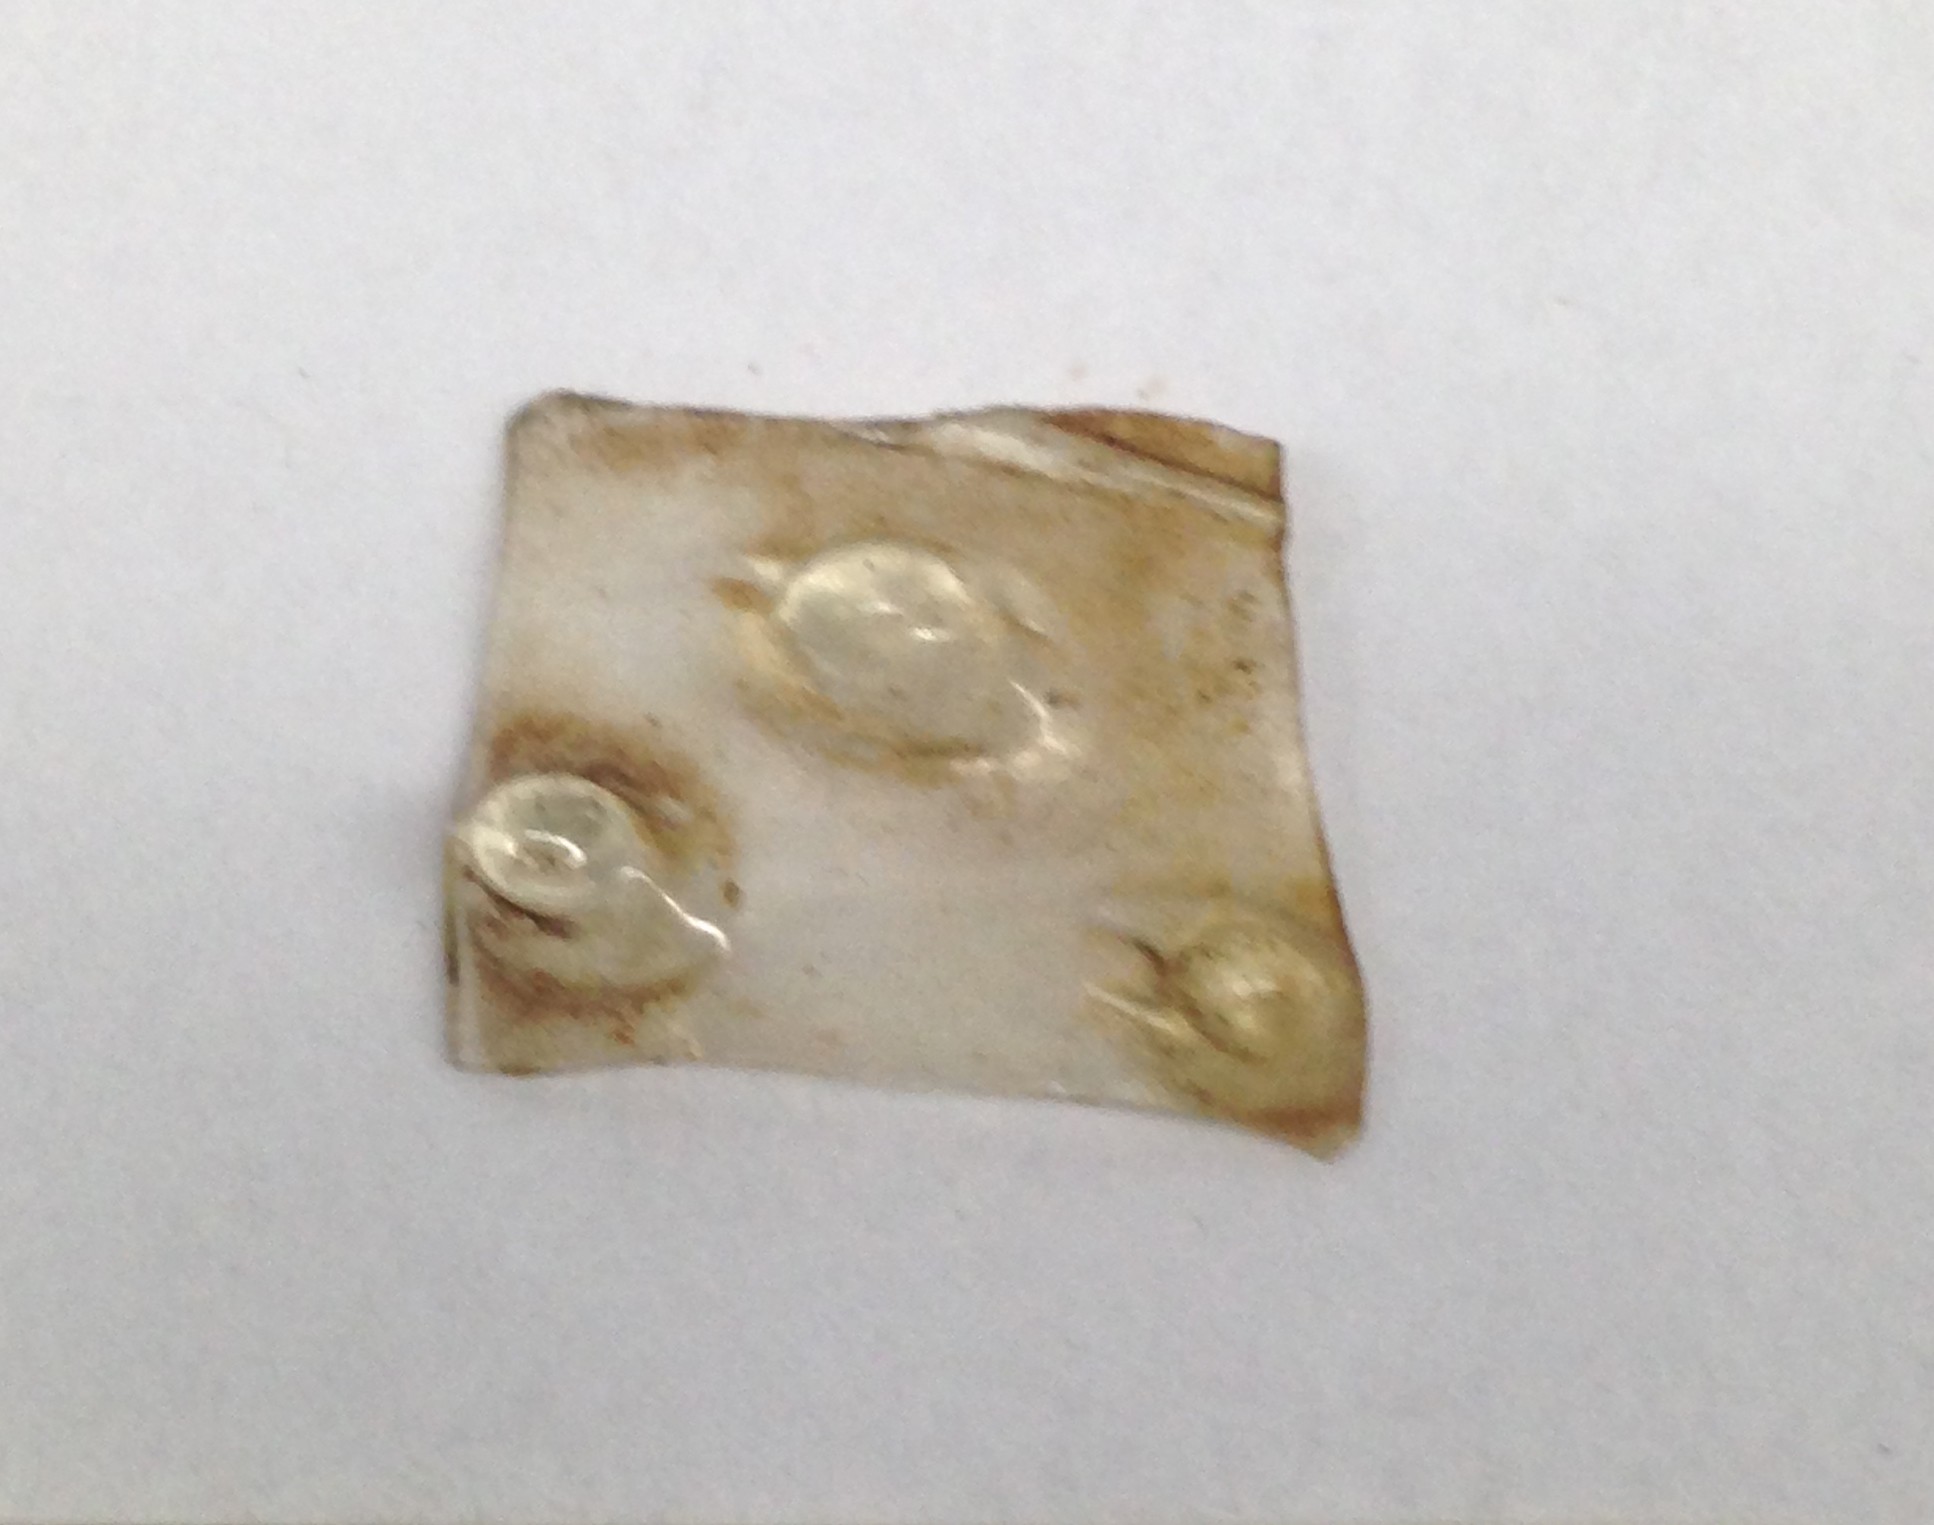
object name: glass fragment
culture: crusader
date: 1201-1300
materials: glass